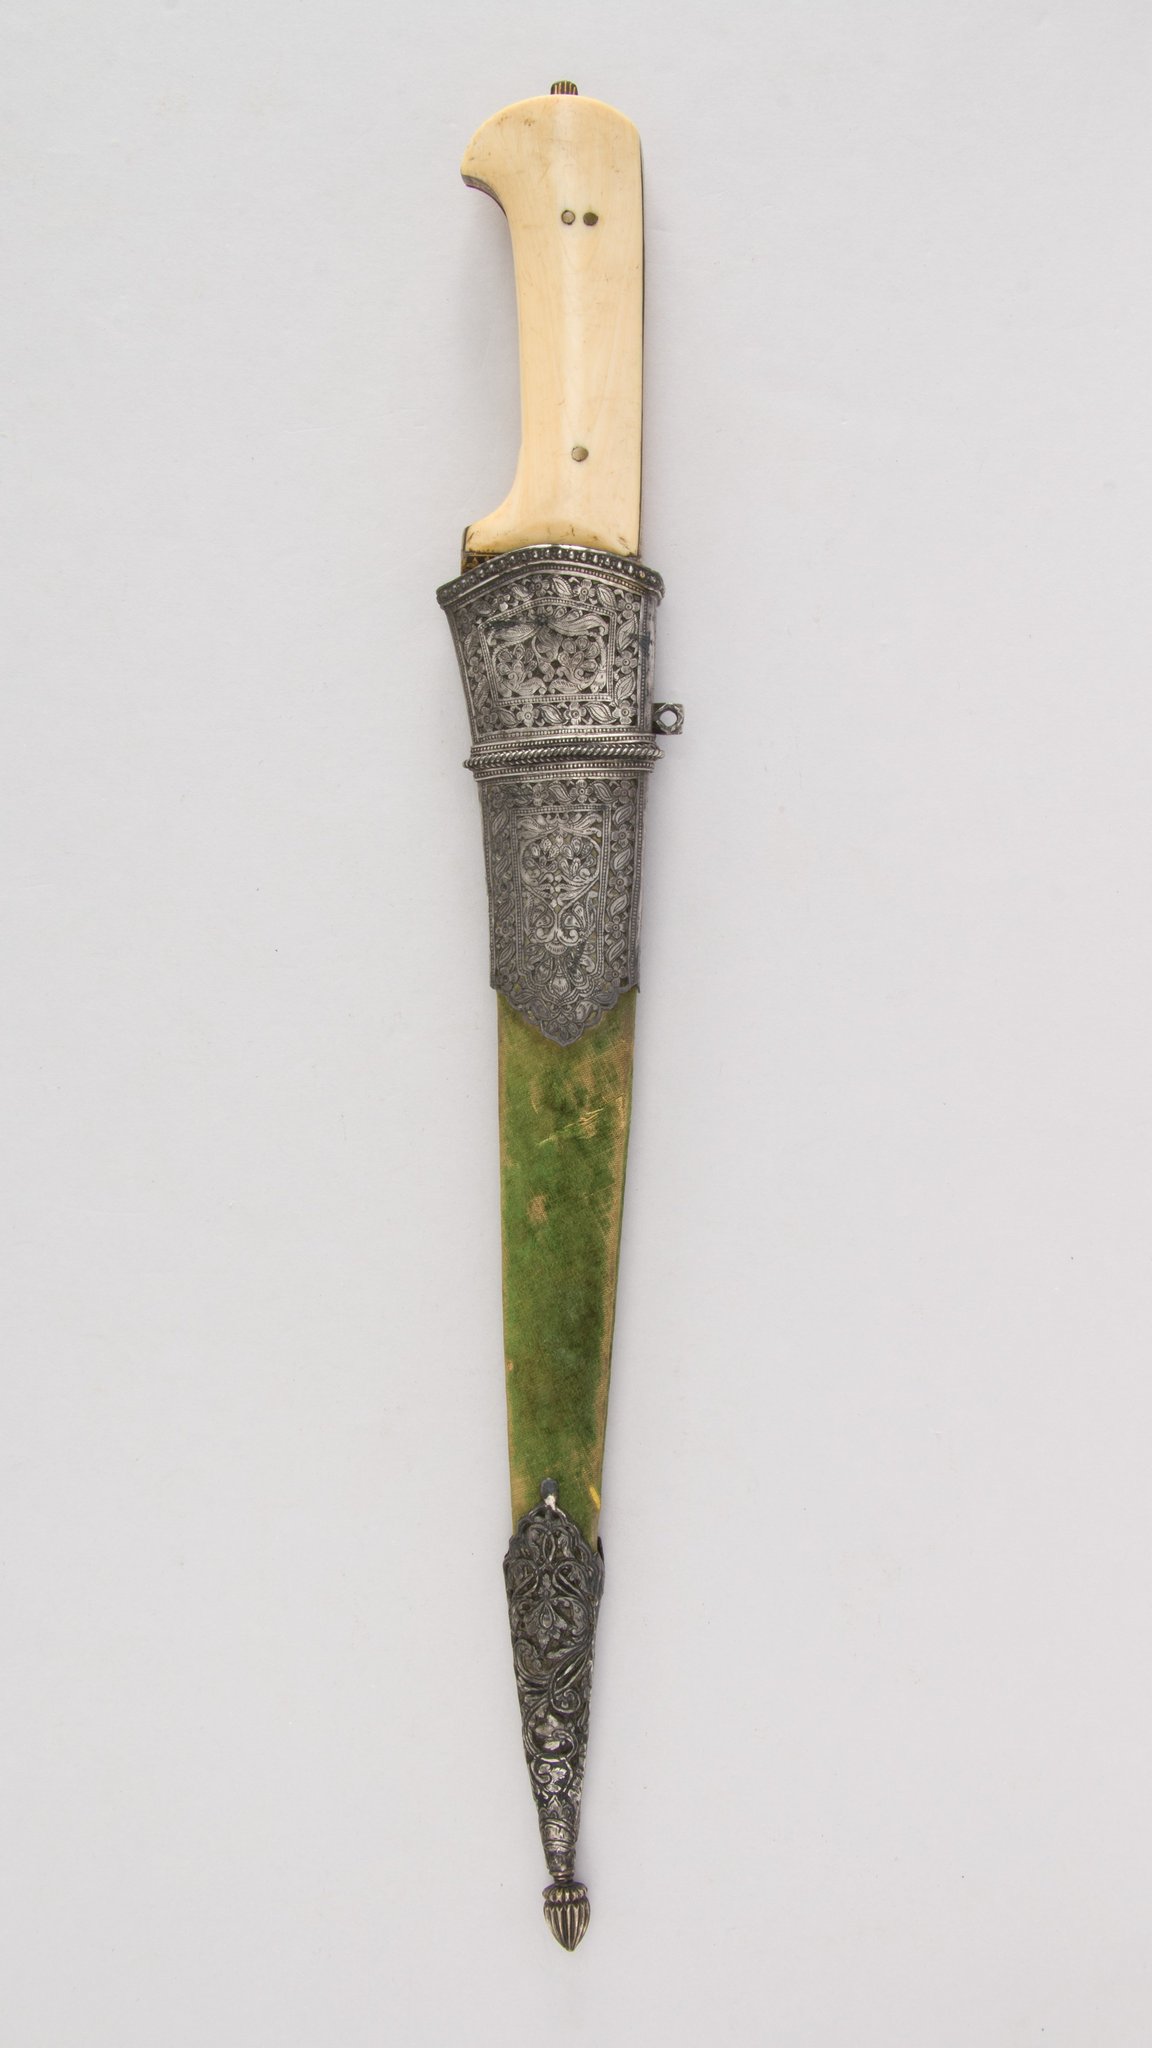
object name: dagger pesh kabz with sheath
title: Dagger (Pesh-kabz) with Sheath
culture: indian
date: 1701-1900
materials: gold, iron, ivory, silver, steel, velvet, wood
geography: india